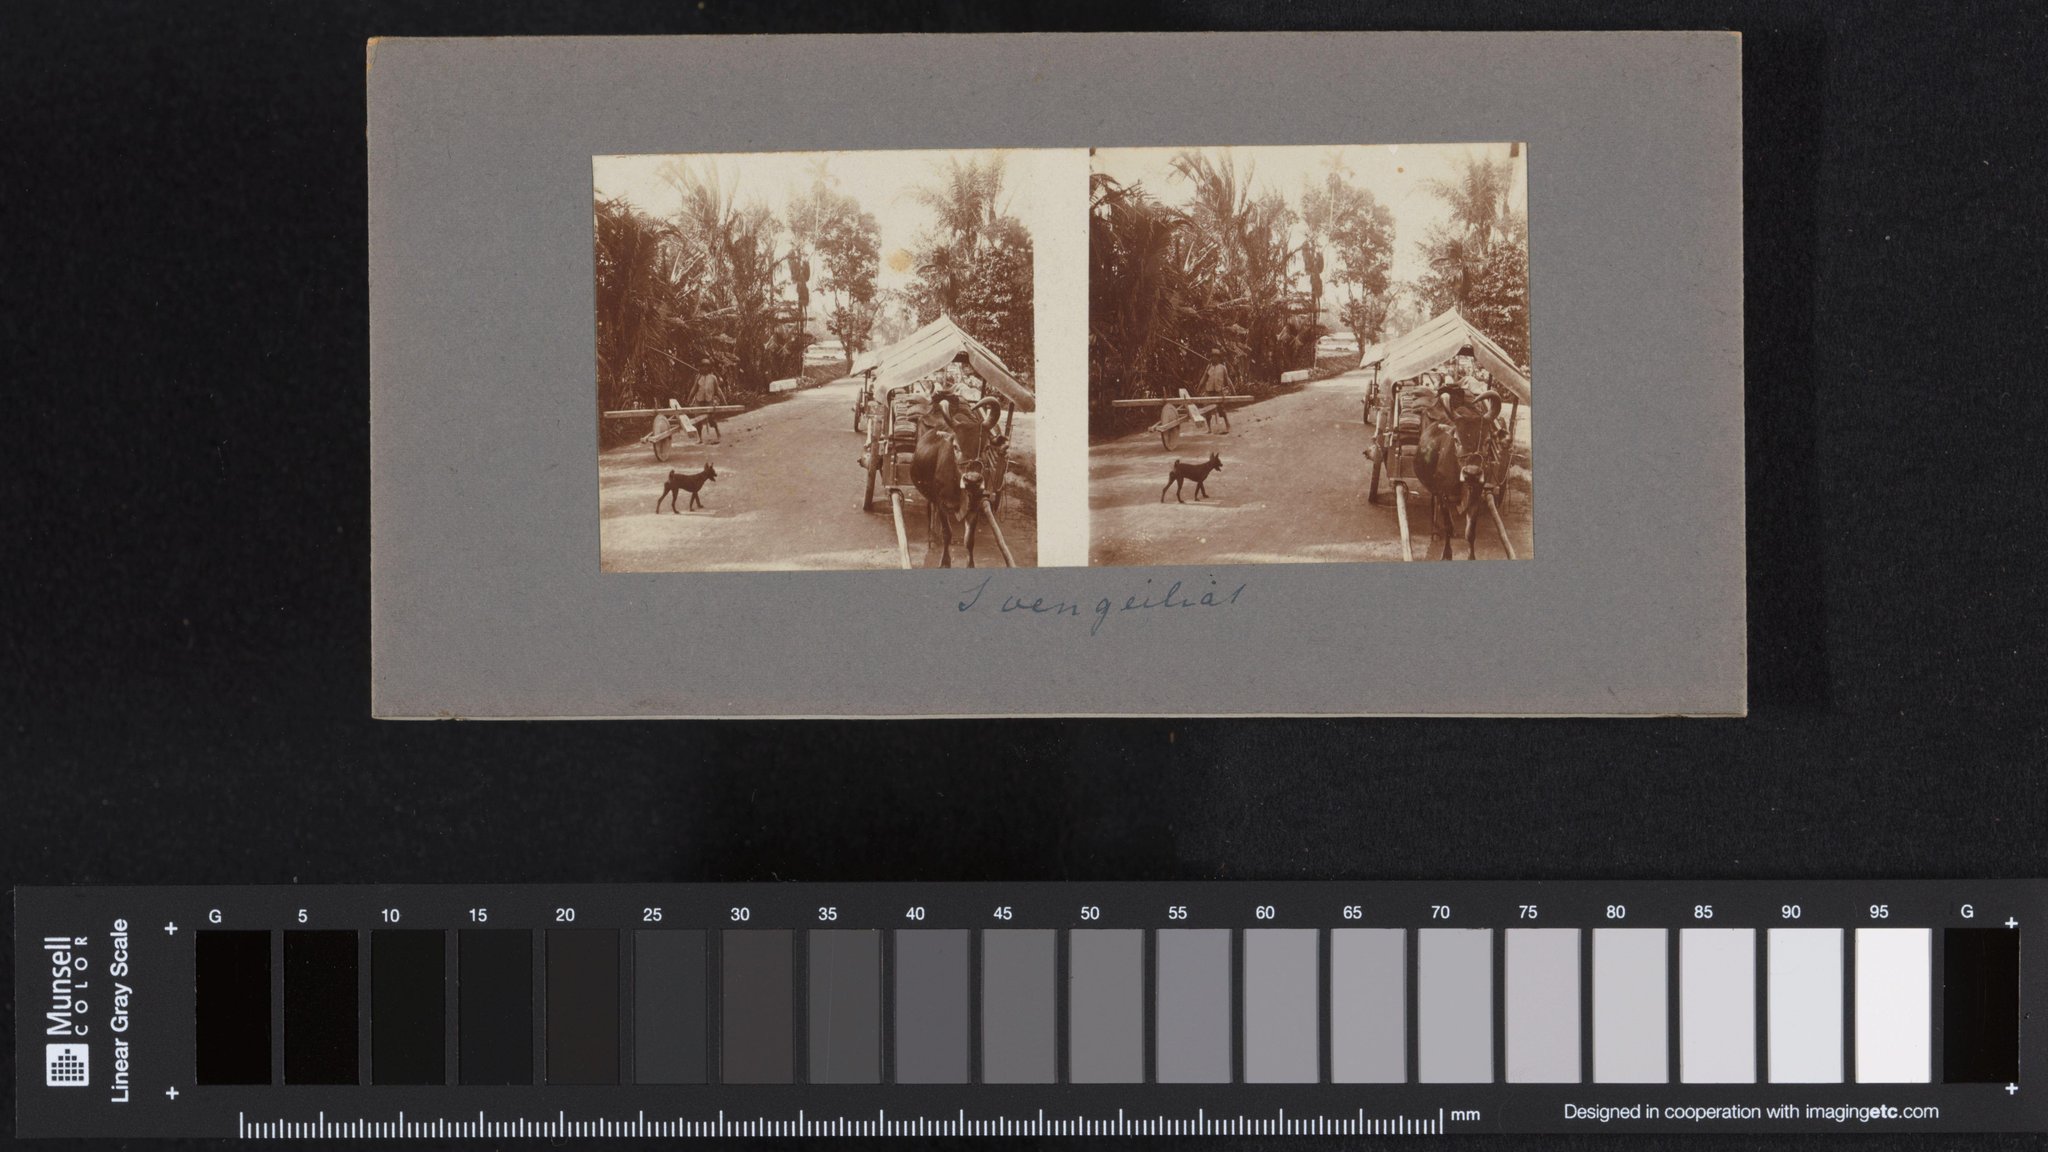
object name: stereograph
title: Straatgezicht Soengeiliat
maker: robert julius boers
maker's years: 1867-1932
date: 1900-1922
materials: cardboard, photographic support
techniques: gelatin silver print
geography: bangka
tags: robert julius boers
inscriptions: inscription: ‘Soengeiliat’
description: Straatgezicht met ossenwagen en kruier te Soengeiliat op Banka. Onderdeel van een groep stereofoto's van Robert Julius Boers, chef van het staatsbedrijf de Banka-tinwinning op Banka, uit de periode ca. 1900-1922.